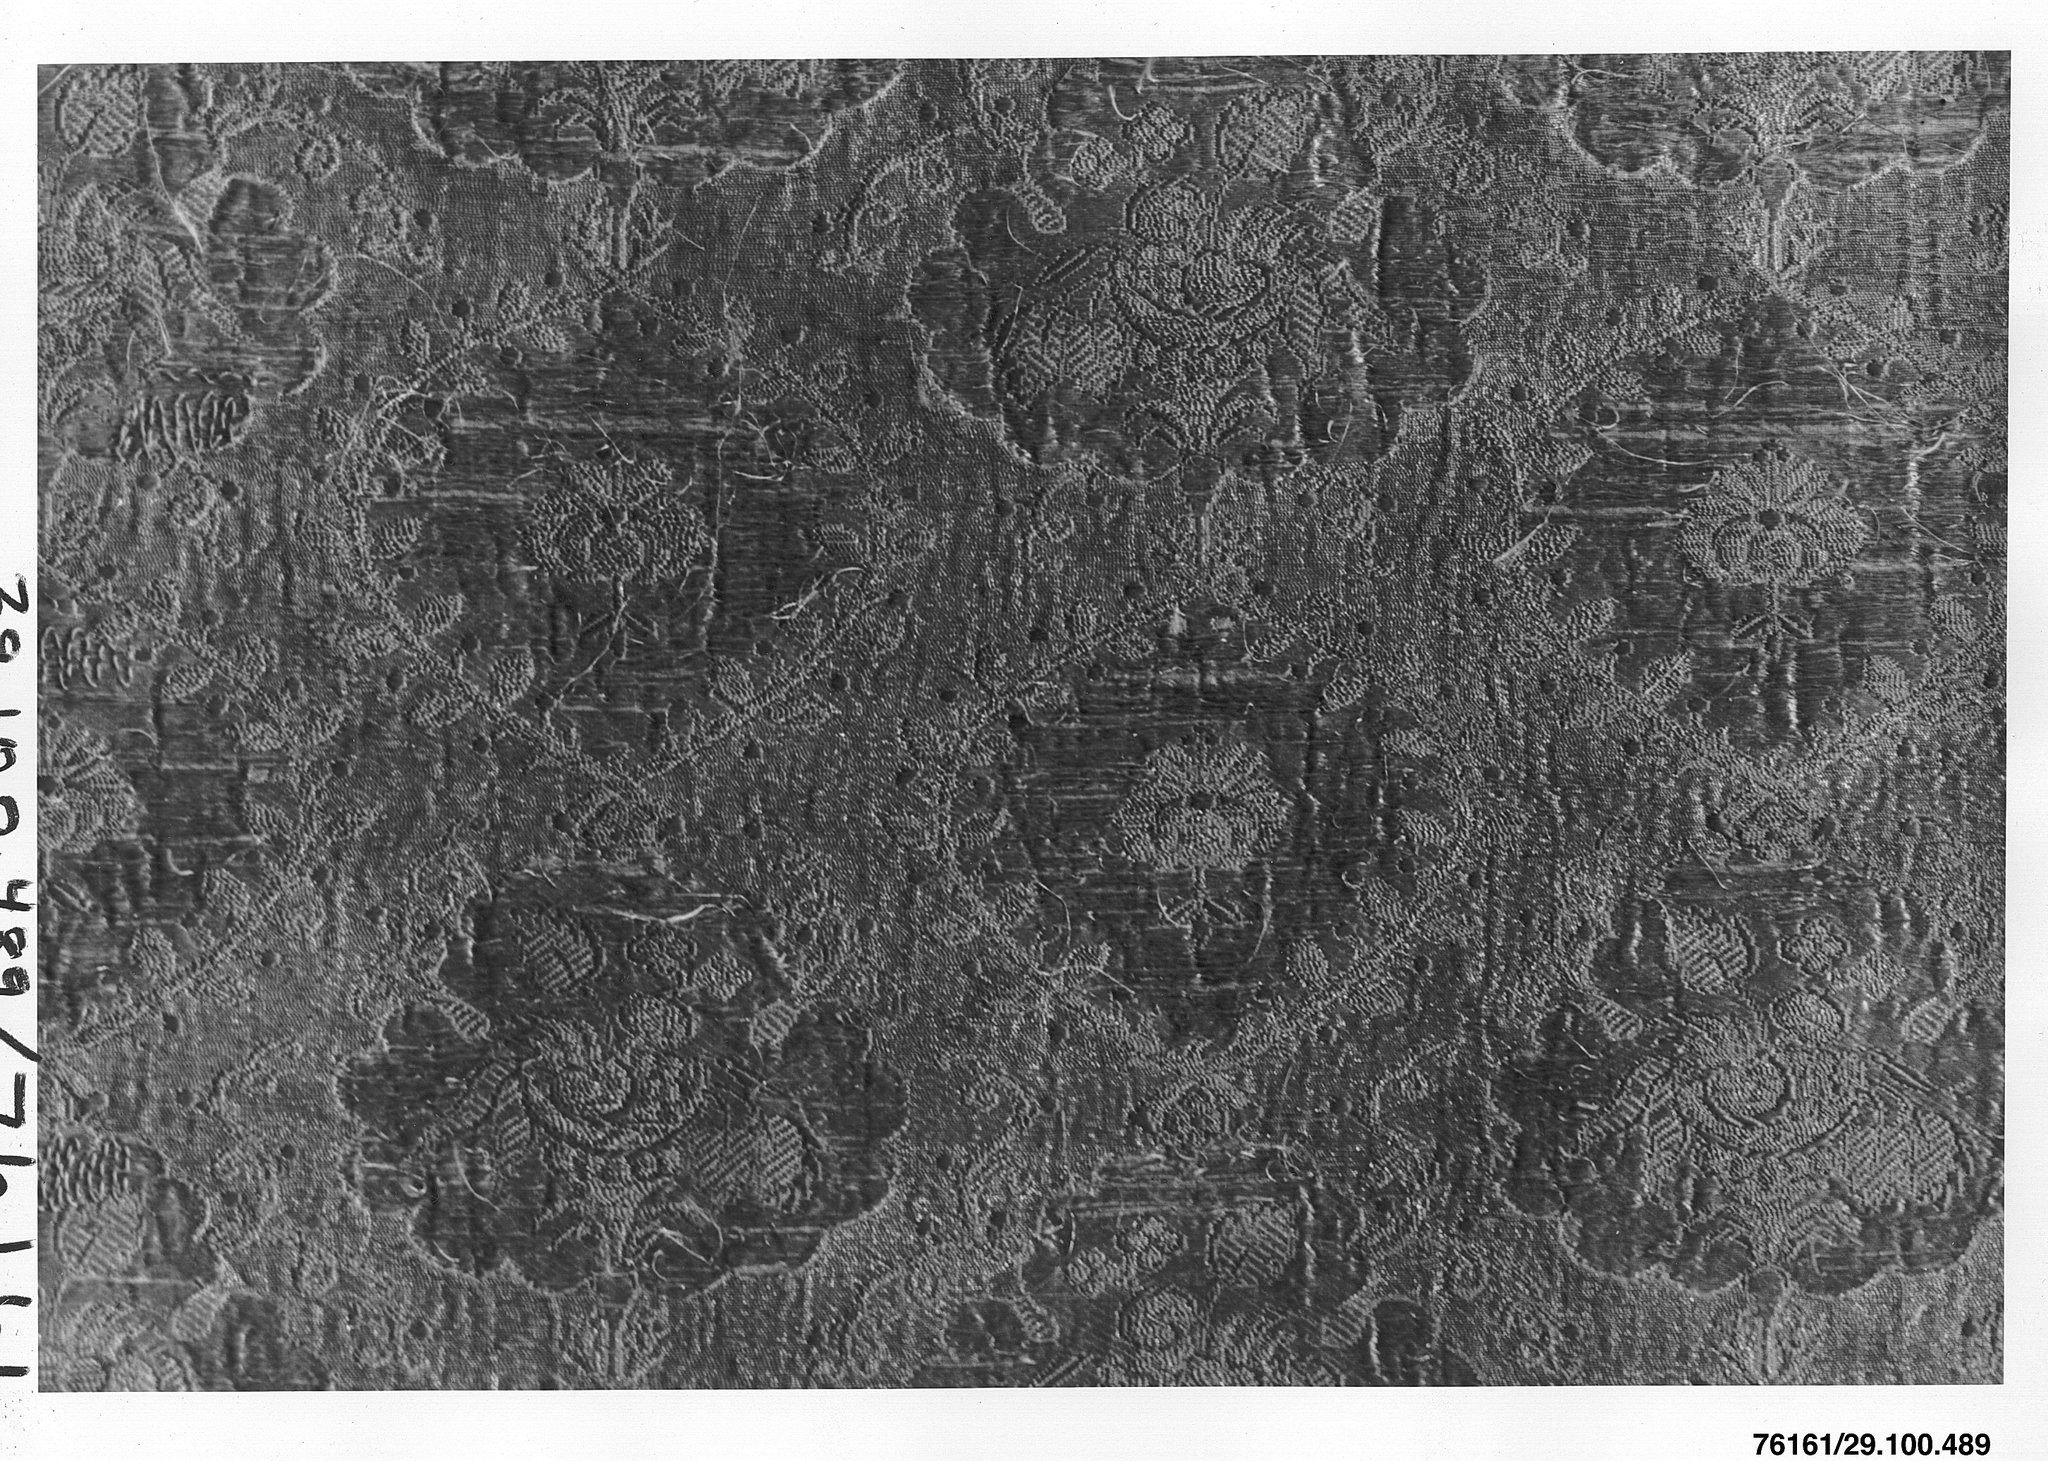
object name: piece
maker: marco ciccani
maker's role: designer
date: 1701-1800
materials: metal thread, silk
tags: flowers